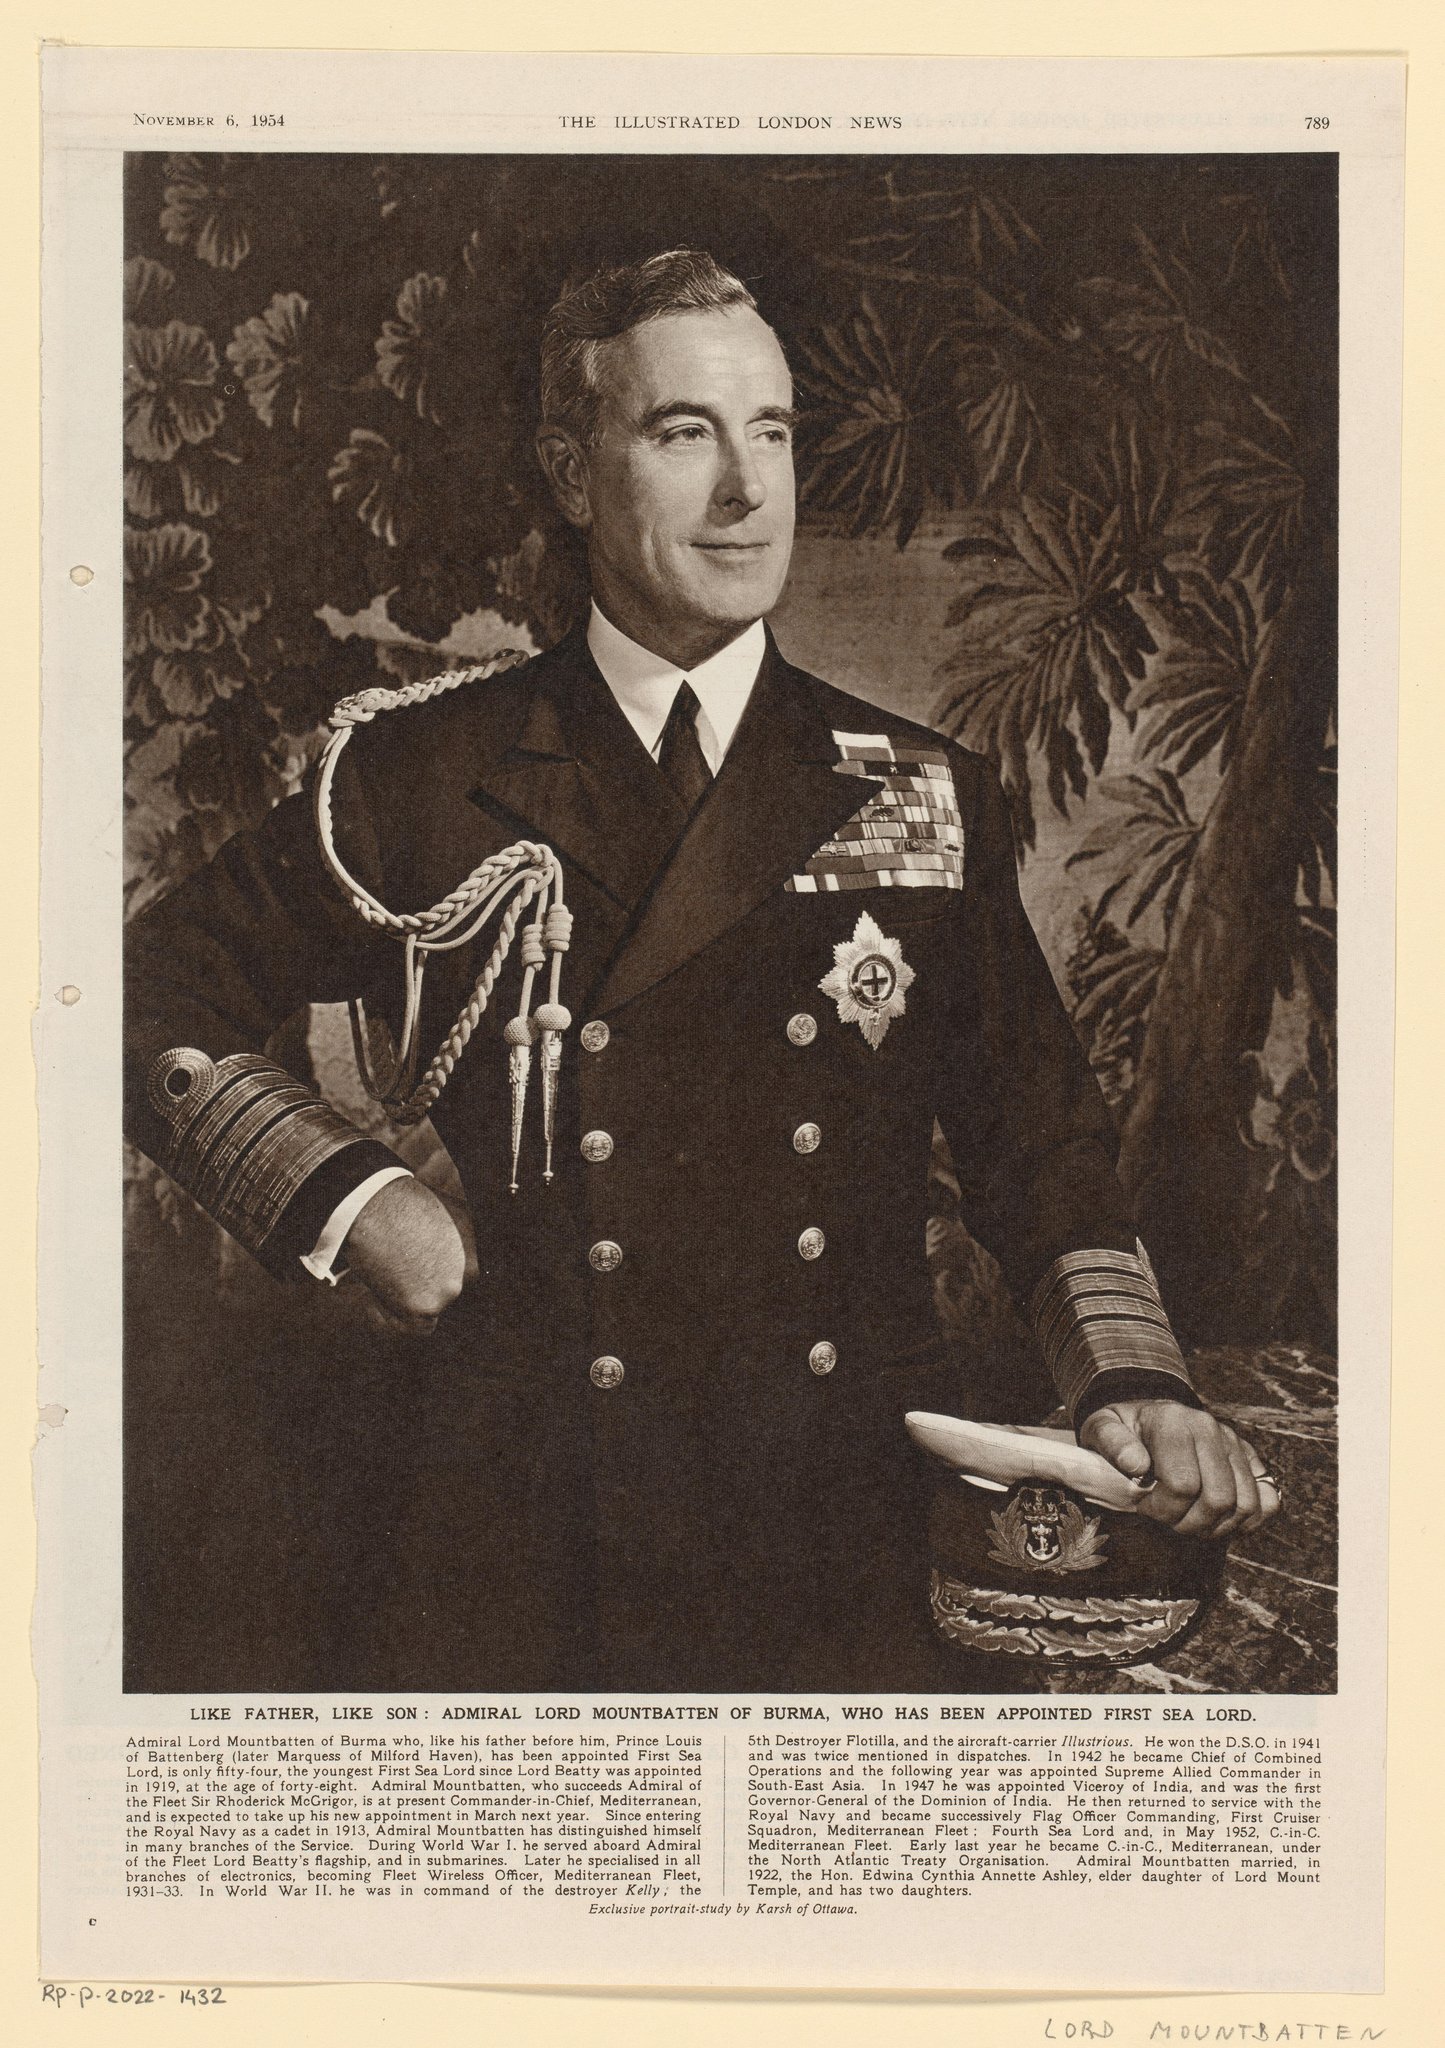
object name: photomechanical print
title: Portret van Louis Mountbatten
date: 1954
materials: paper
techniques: letterpress printing, rotogravure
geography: ottawa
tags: historical persons, officer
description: Afdruk uit: The Illustrated Londen News 249 (1954), p. 789.